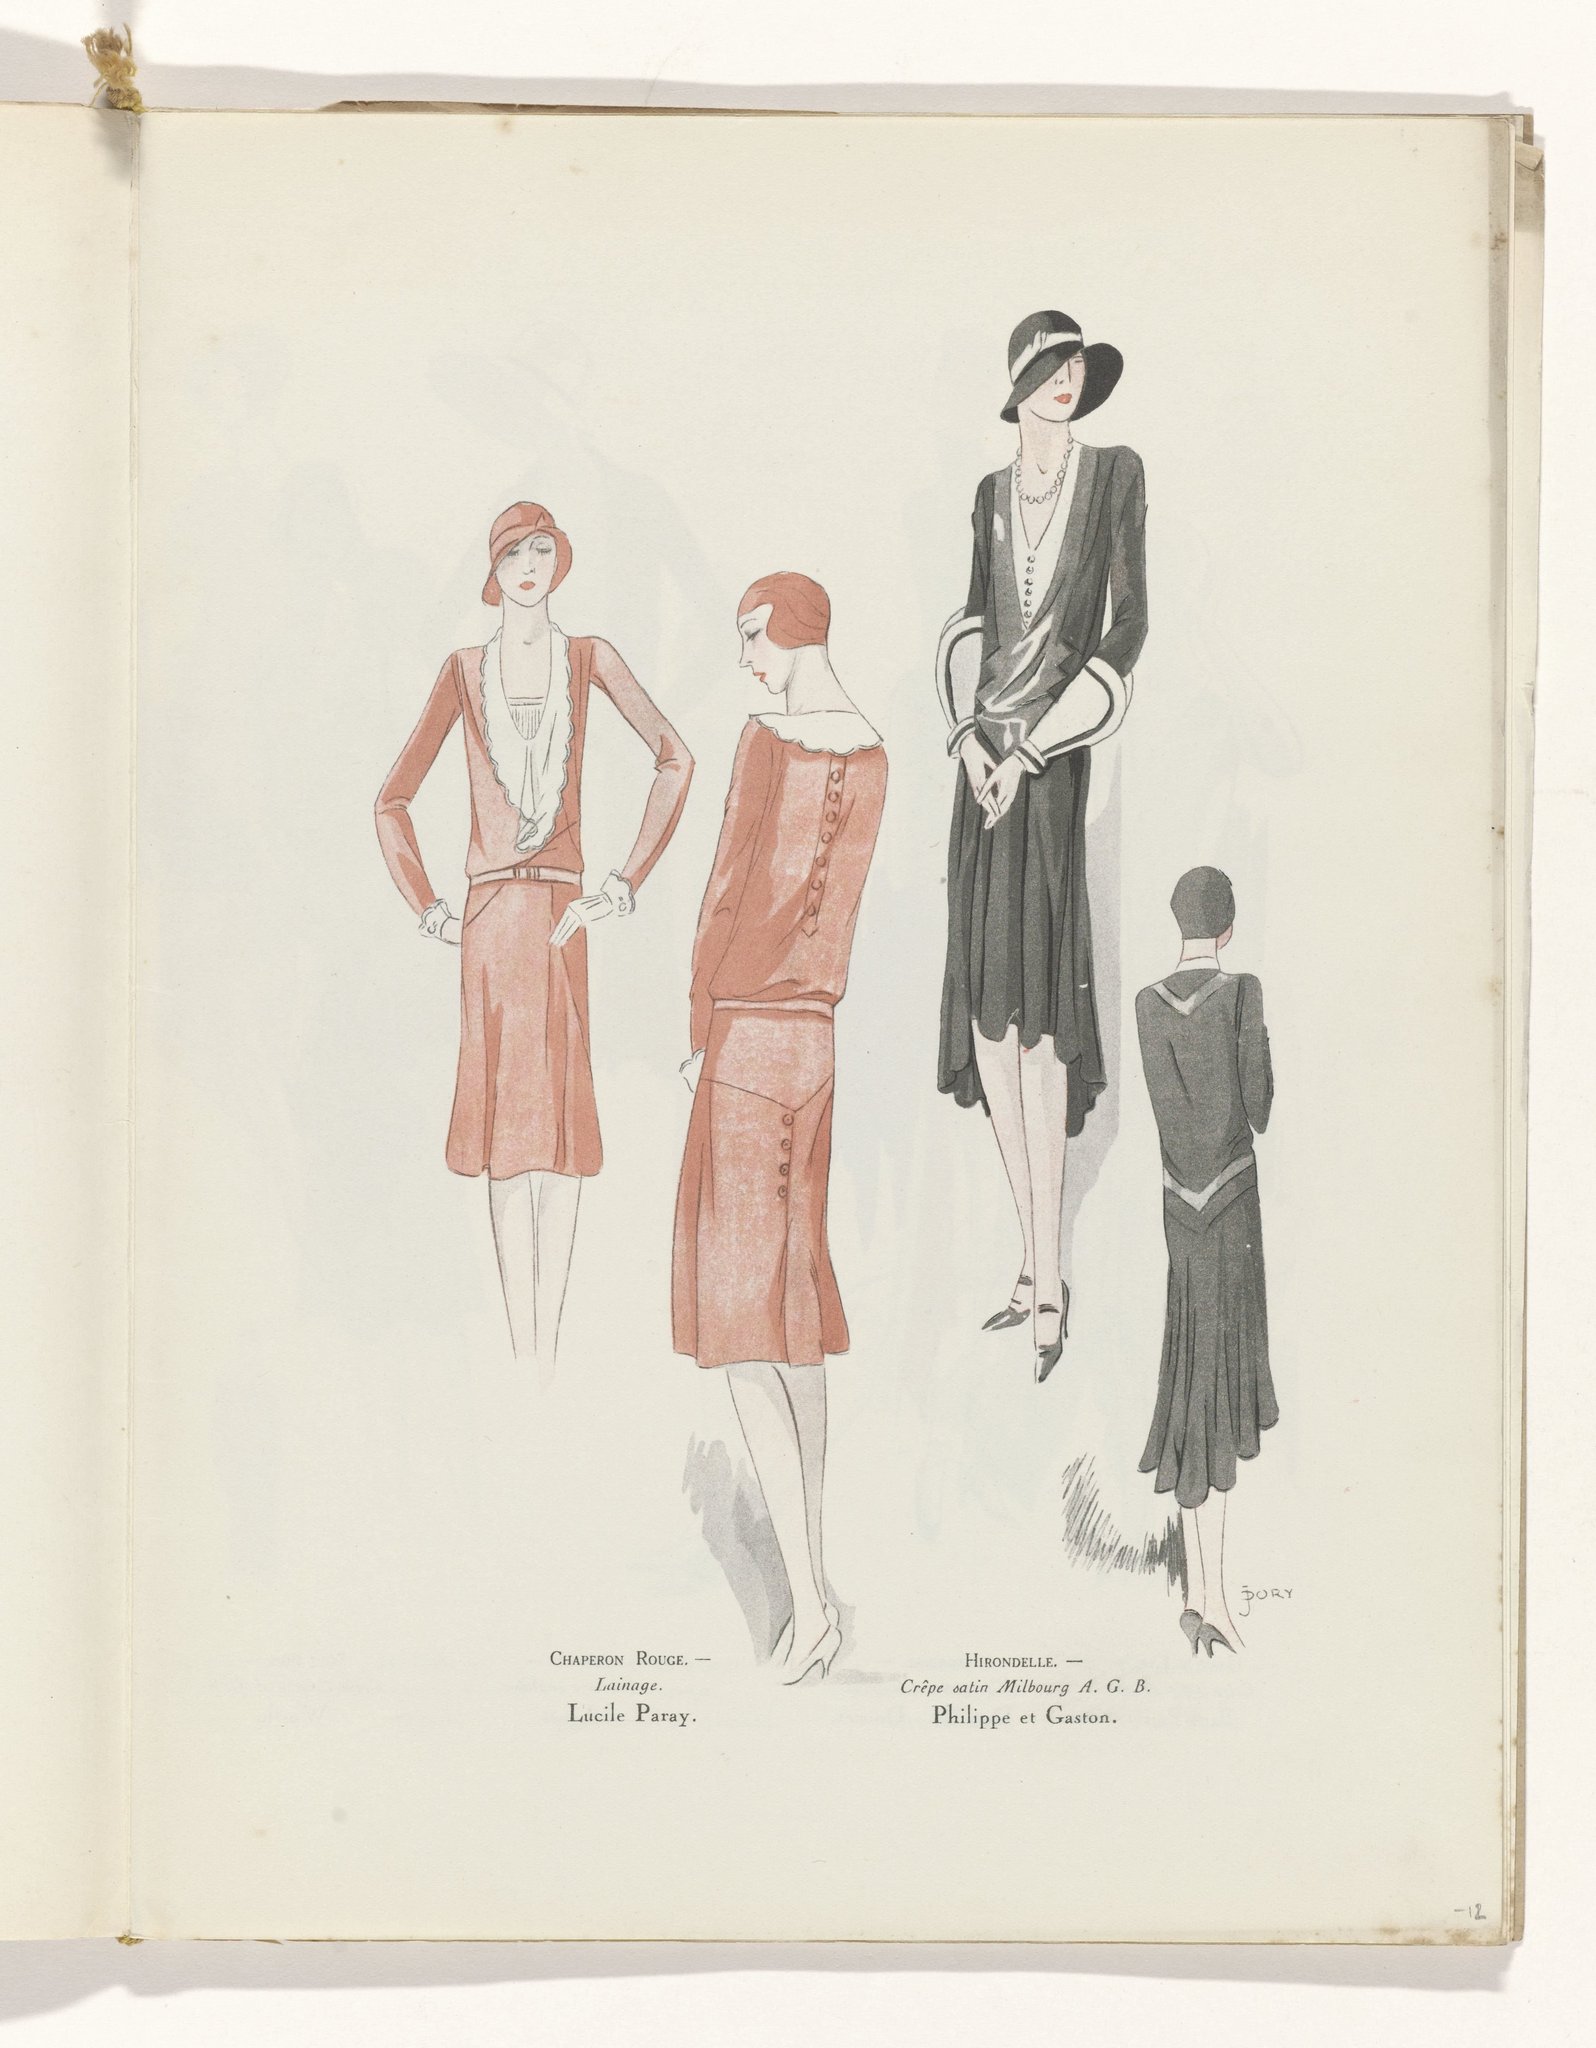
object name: fashion print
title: Art - Goût - Beauté, Feuillets de l' élégance féminine, Juin 1929, No. 106, 9e Année, p.12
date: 1929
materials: paper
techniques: printing, photography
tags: gloves, mittens (short gloves) (+ women's clothes), fashion plates, sleeves: cuffs (+ women's clothes), dress, gown (+ women's clothes), necklace (+ women's clothes)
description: Japon van rode wol van Lucile Paray; japon van zwarte 'crêpe satin' Milbourg A.G.B. van Philippe et Gaston. Pagina uit het modetijdschrift Art-Goût-Beauté (1920-1933).